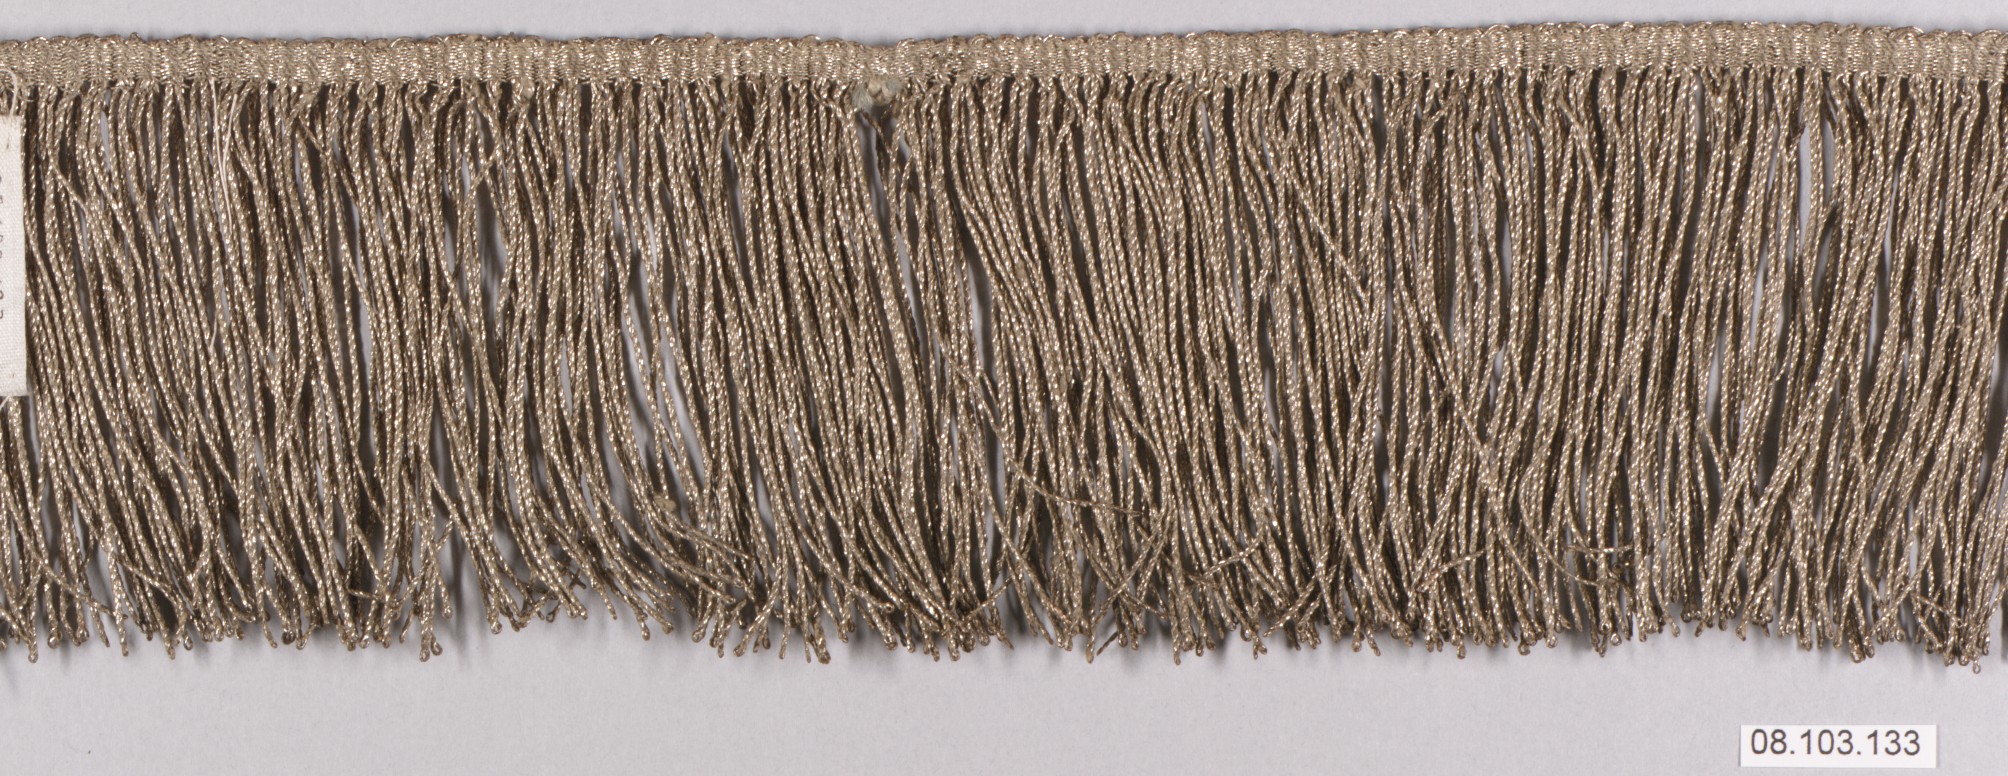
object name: fringe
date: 1701-1733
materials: metal thread